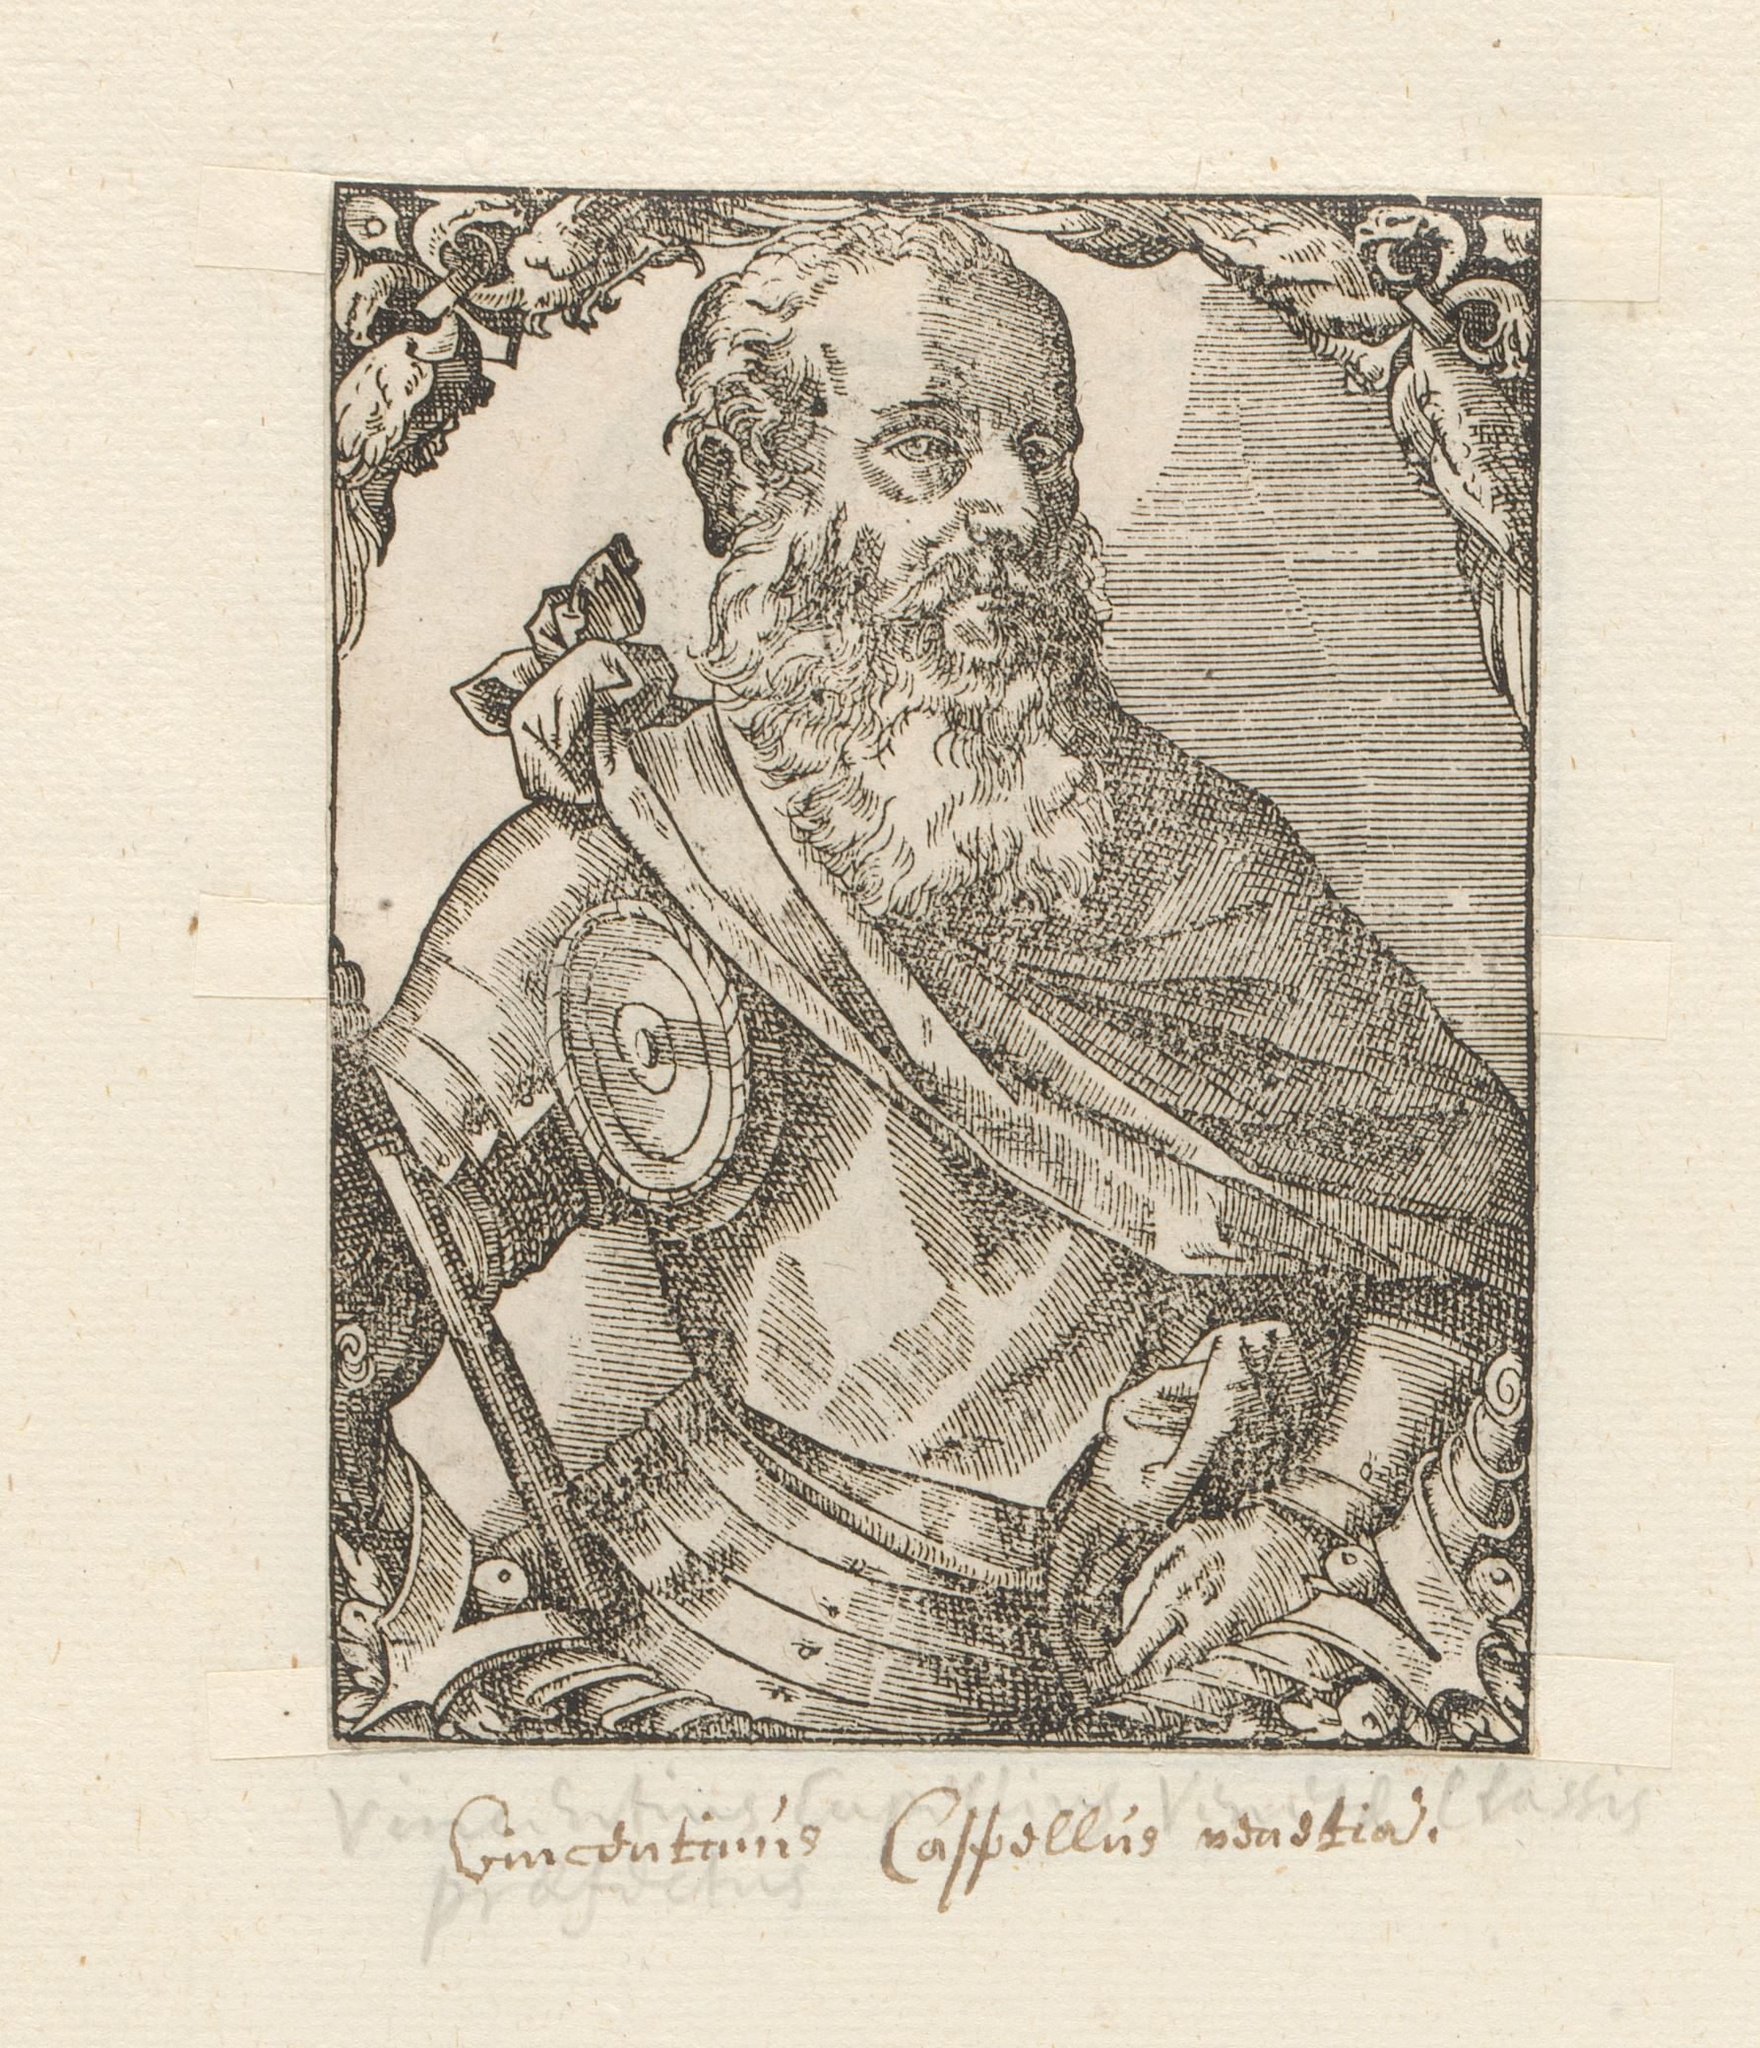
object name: book illustration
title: Portret van Vincenzo Cappello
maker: Anonymous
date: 1549-1575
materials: paper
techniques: woodcut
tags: venice, historical persons, commander-in-chief, admiral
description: Prent gebruikt in: Giovio, Paolo. Elogia Virorum bellica virtute illustrium (...). Bazel: Peter Perna, 1575.